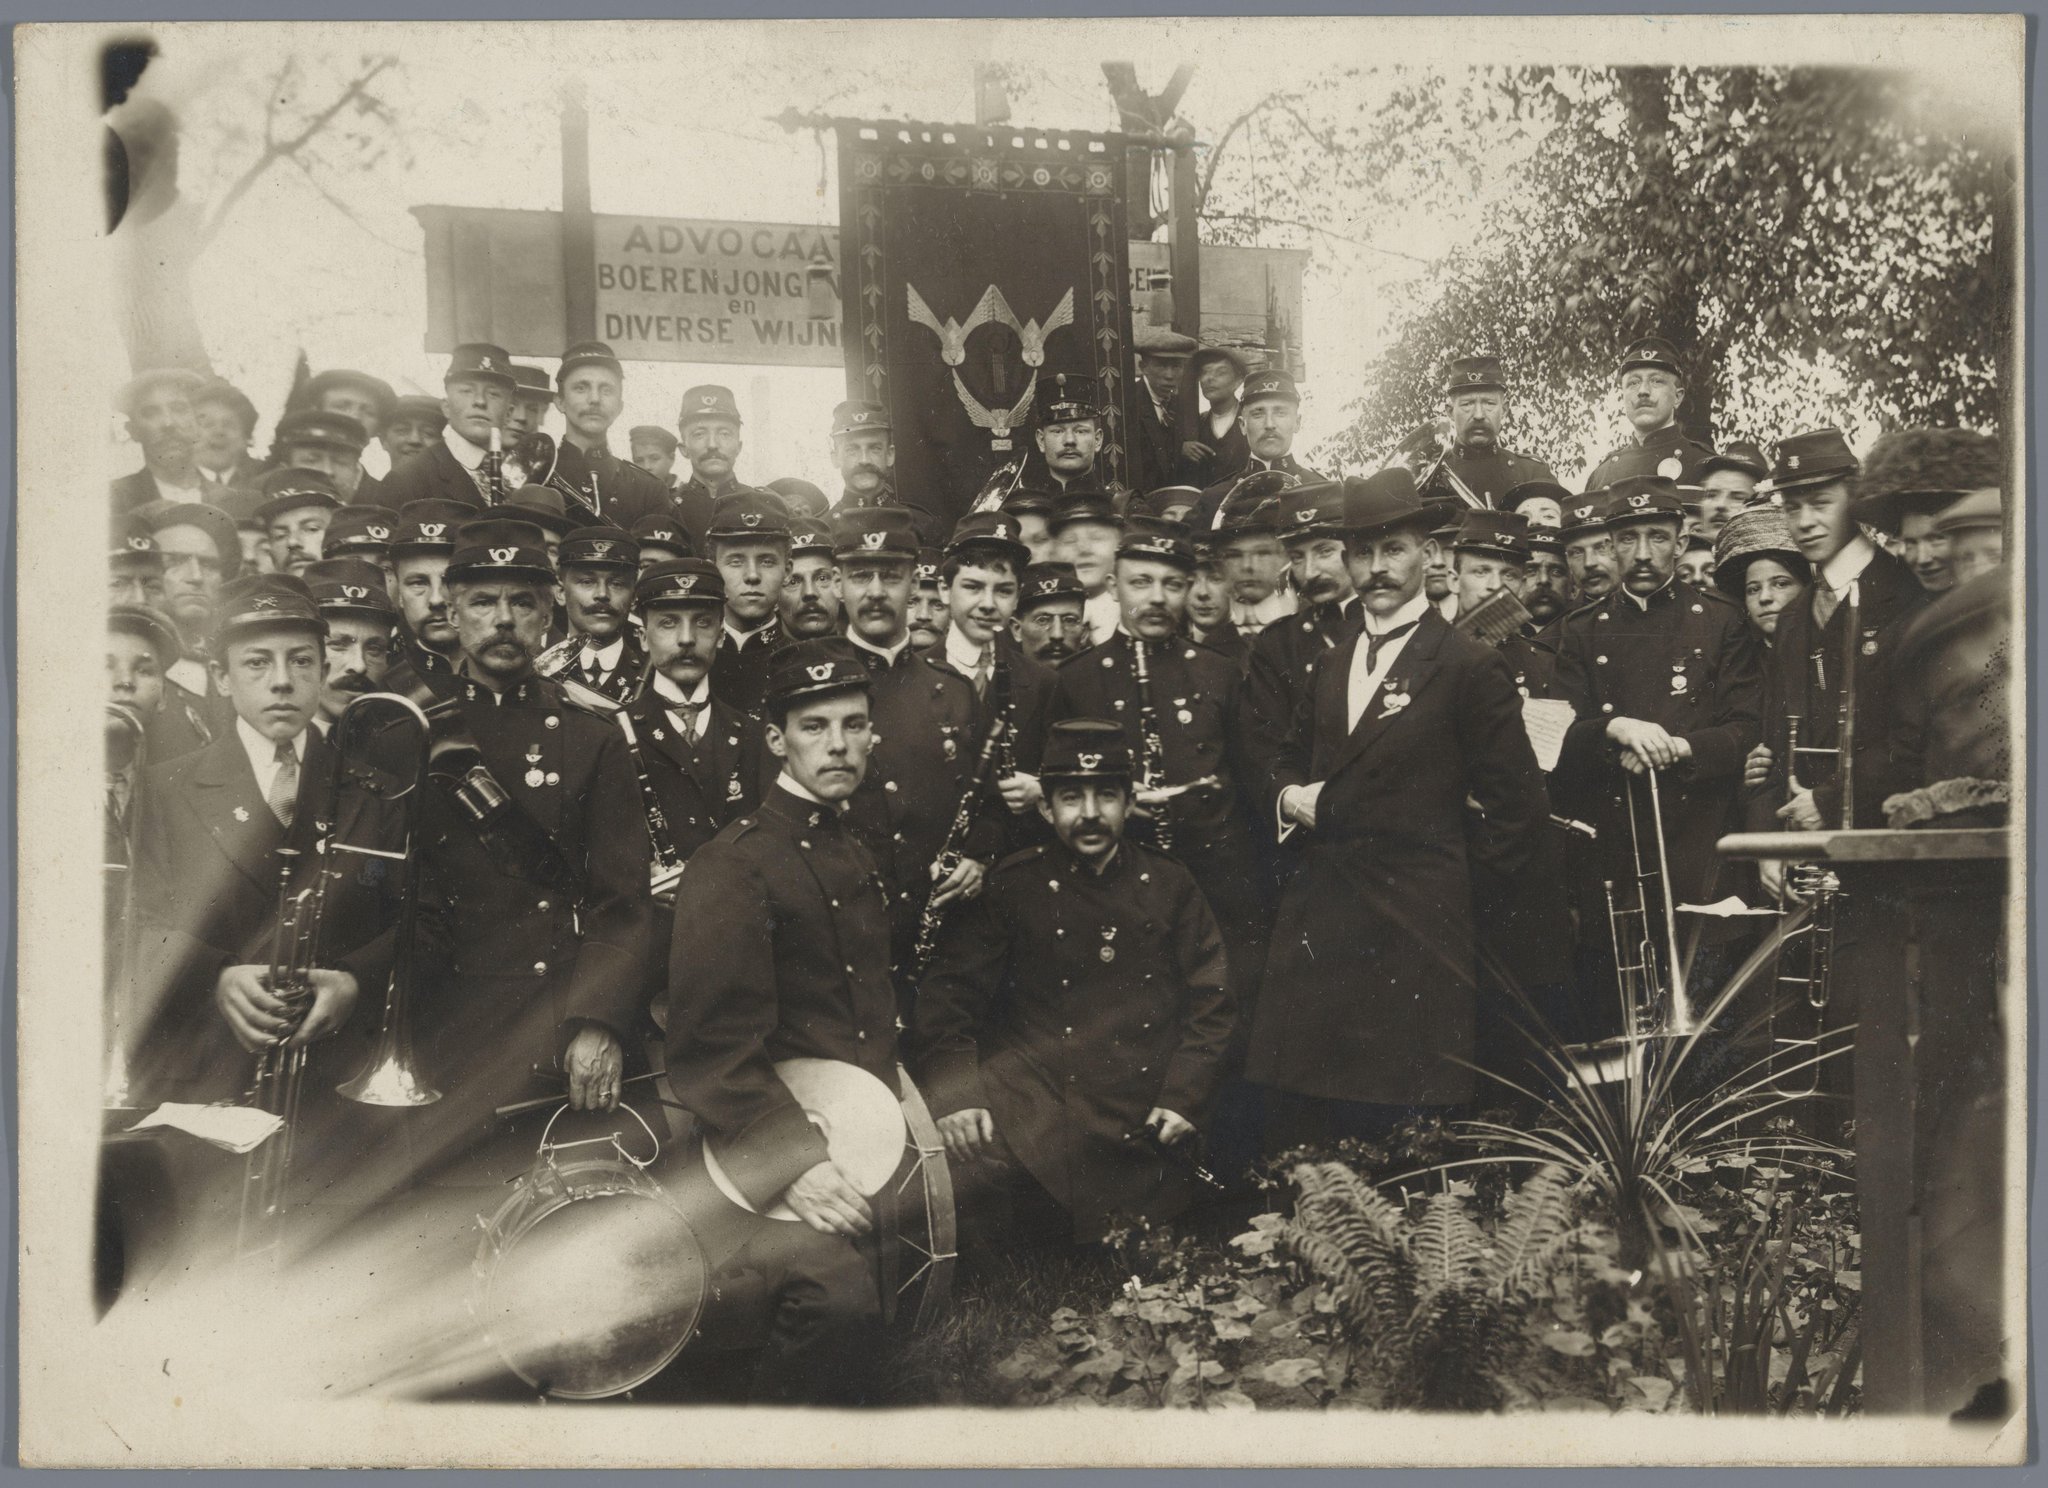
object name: photograph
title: Groepsfoto van de Amsterdamsche Postharmonie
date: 1920-1940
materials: photographic support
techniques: gelatin silver print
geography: amsterdam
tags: musician, banner, standard (as symbol of the state, etc.), anonymous historical persons portrayed in a group, in a group-portrait, amsterdam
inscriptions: number: ‘6’, stamp: ‘Illustratie Afdeeling van het / Persbureau M. S. Vaz Dias / Keizersgracht 130. Amsterdam. / Tous droits reservés.’